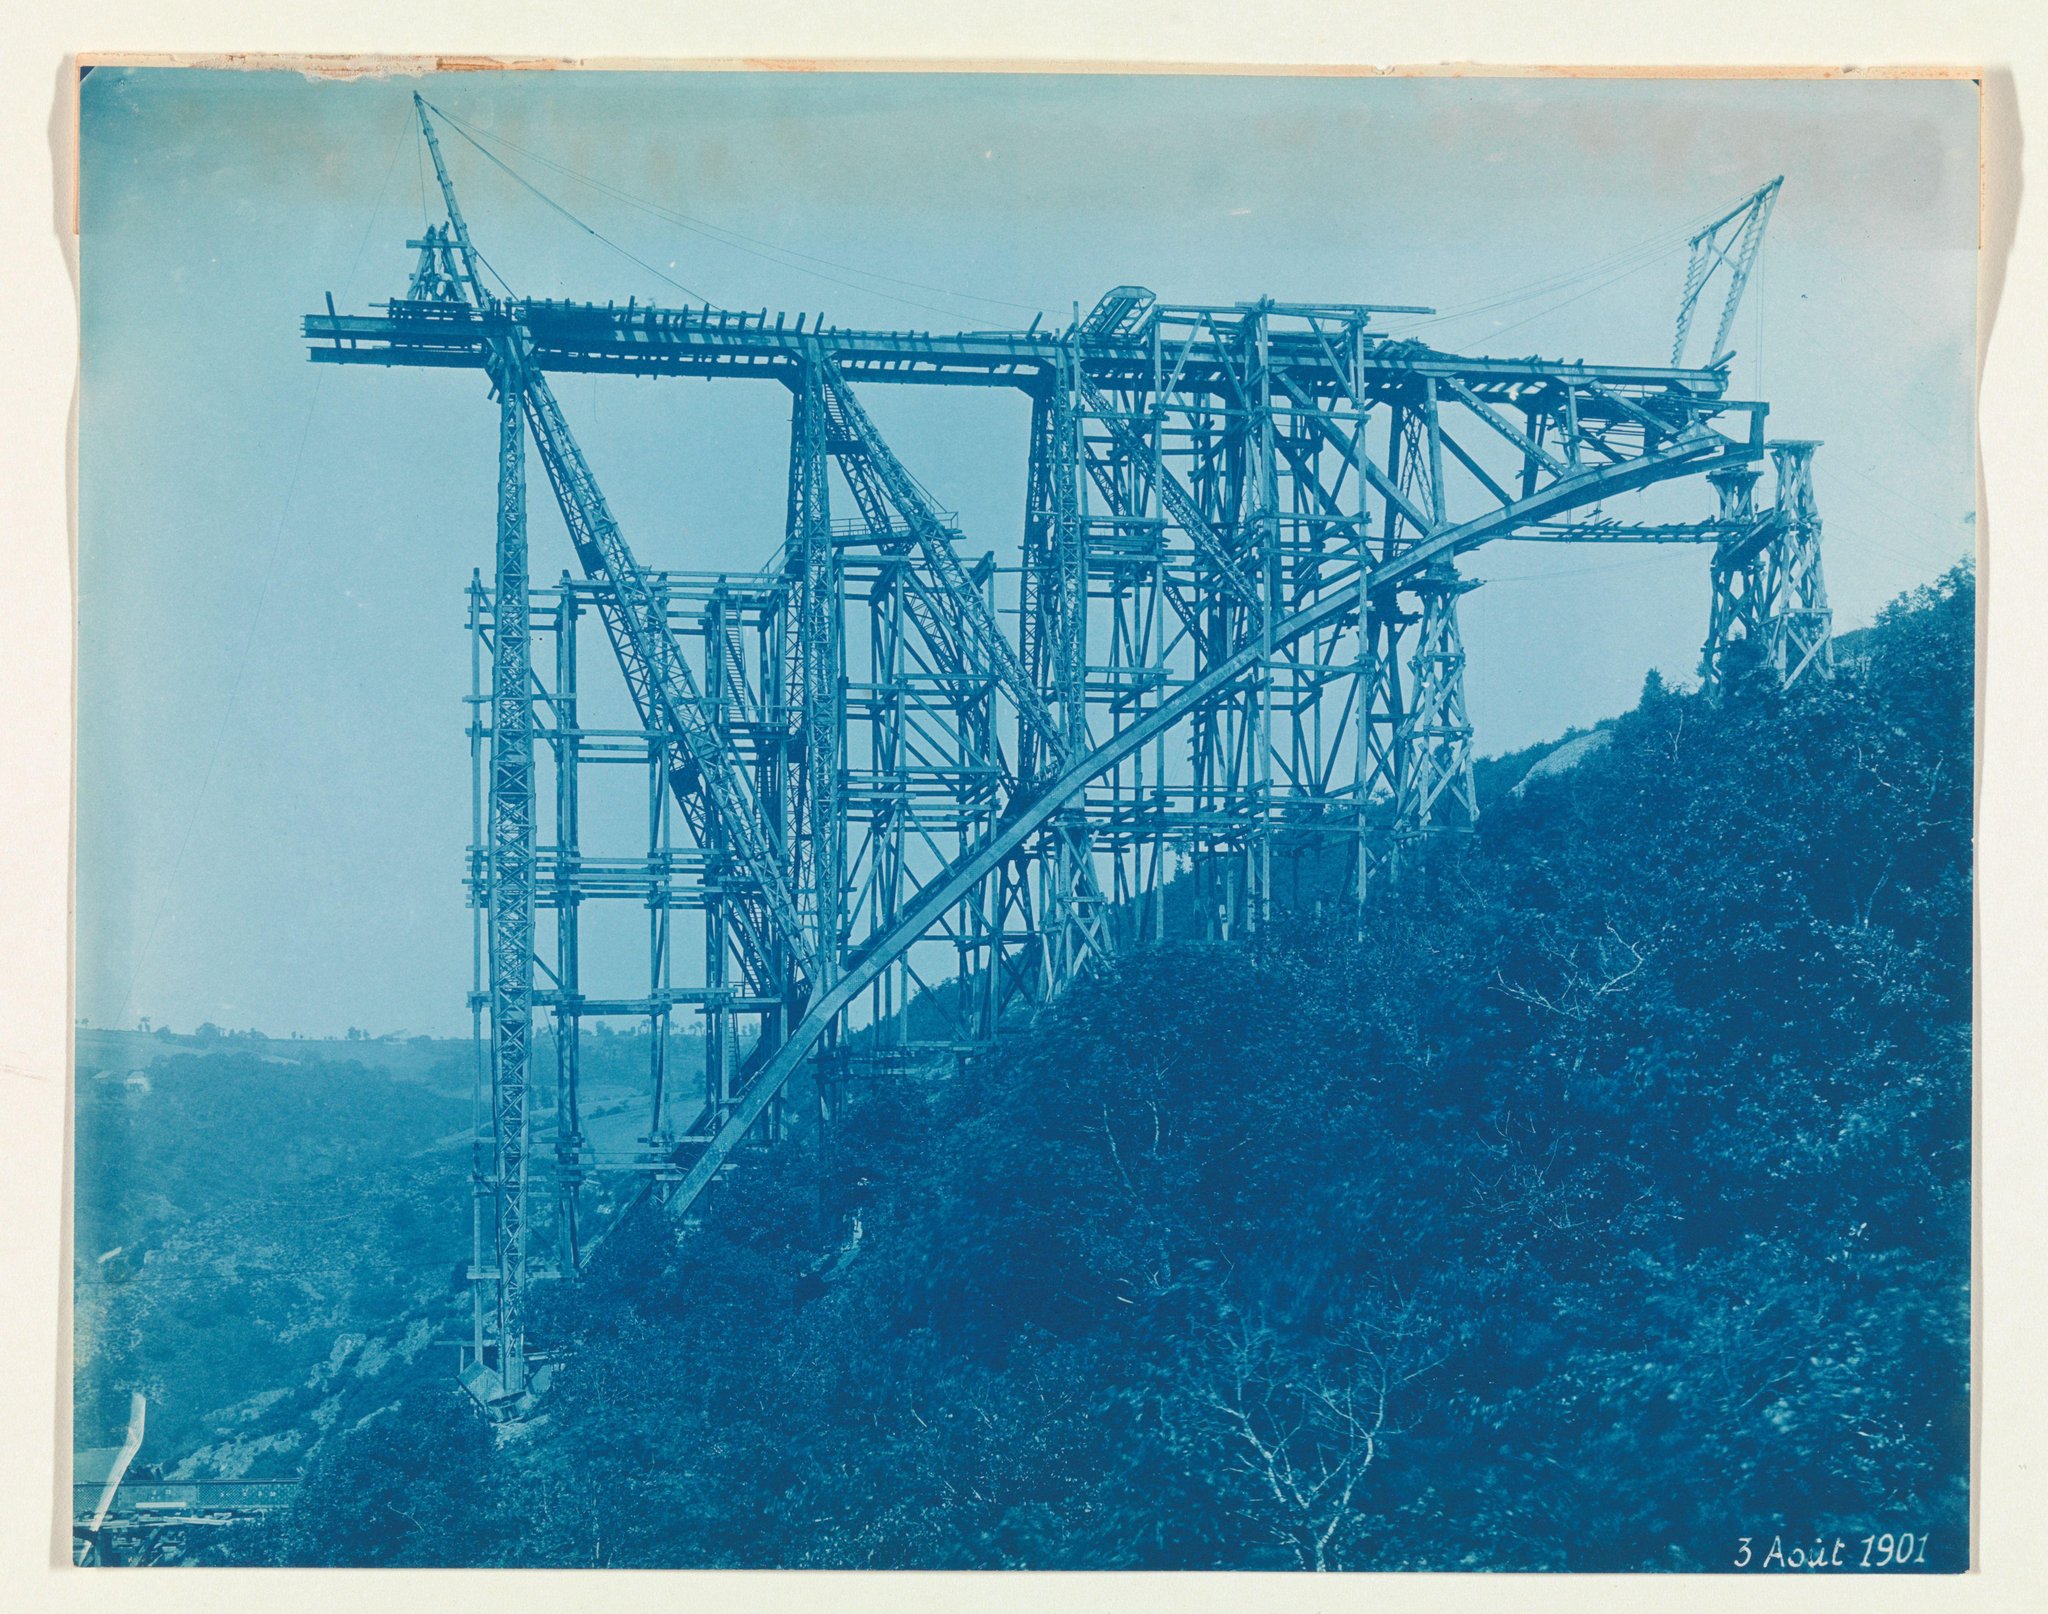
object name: photograph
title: Aanleg van het Viaur Viaduct in Frankrijk door de Societé de Construction des Battignolles, 3 augustus 1901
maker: Anonymous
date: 1901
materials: photographic support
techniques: cyanotype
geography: france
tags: viaduct, making the overground structures (~ building activities)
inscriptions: date